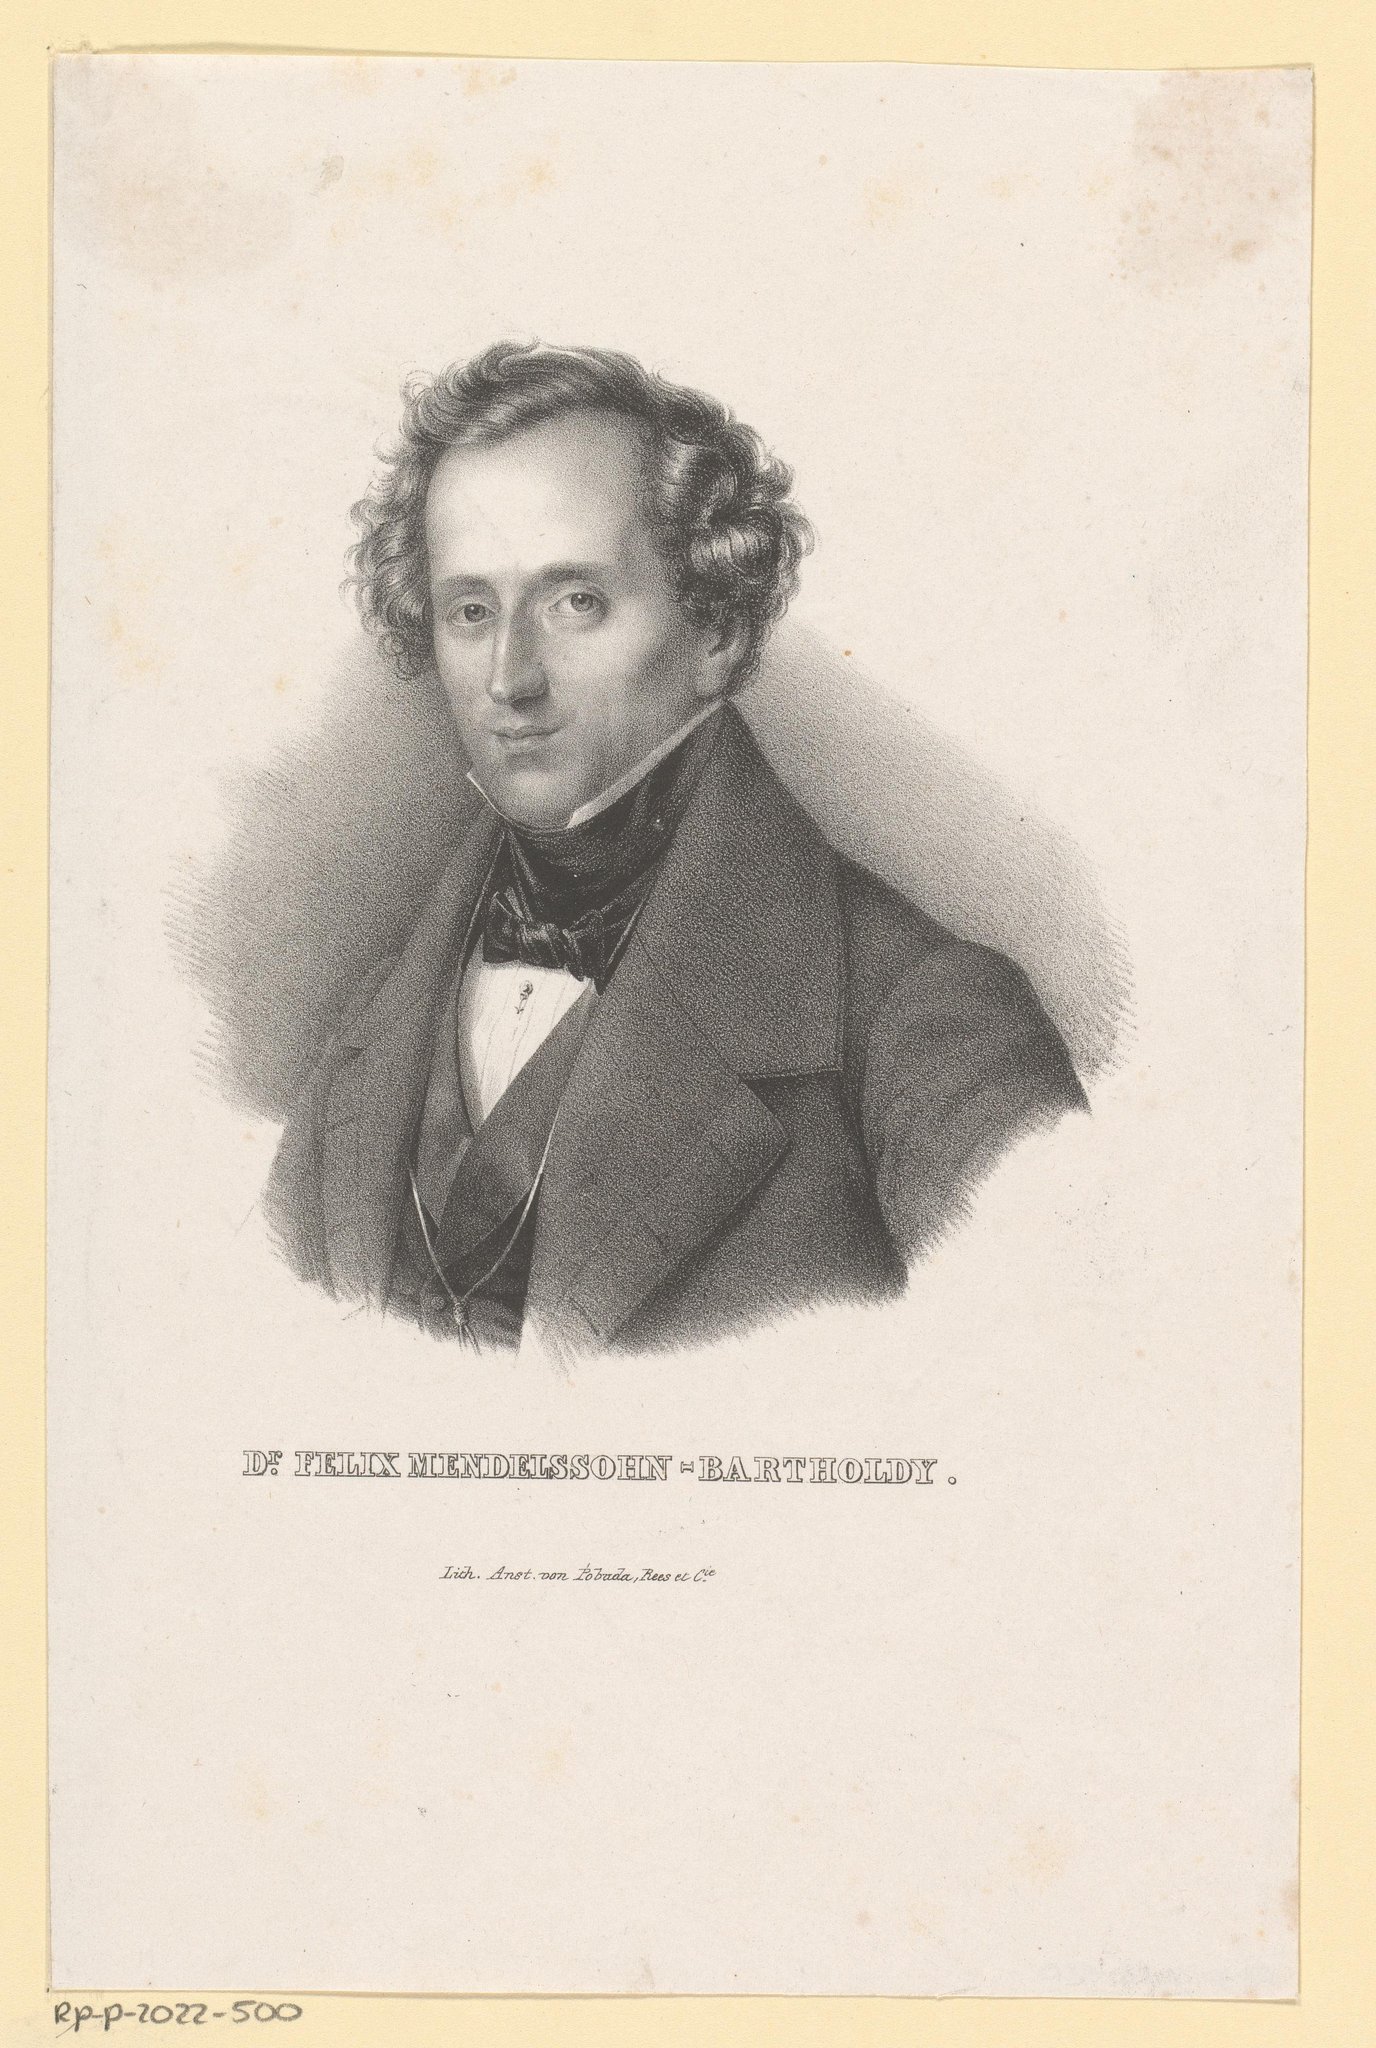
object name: print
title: Dr. Felix Mendelssohn-Bartholdy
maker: Anonymous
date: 1833-1847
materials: paper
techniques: lithograph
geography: stuttgart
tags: historical persons